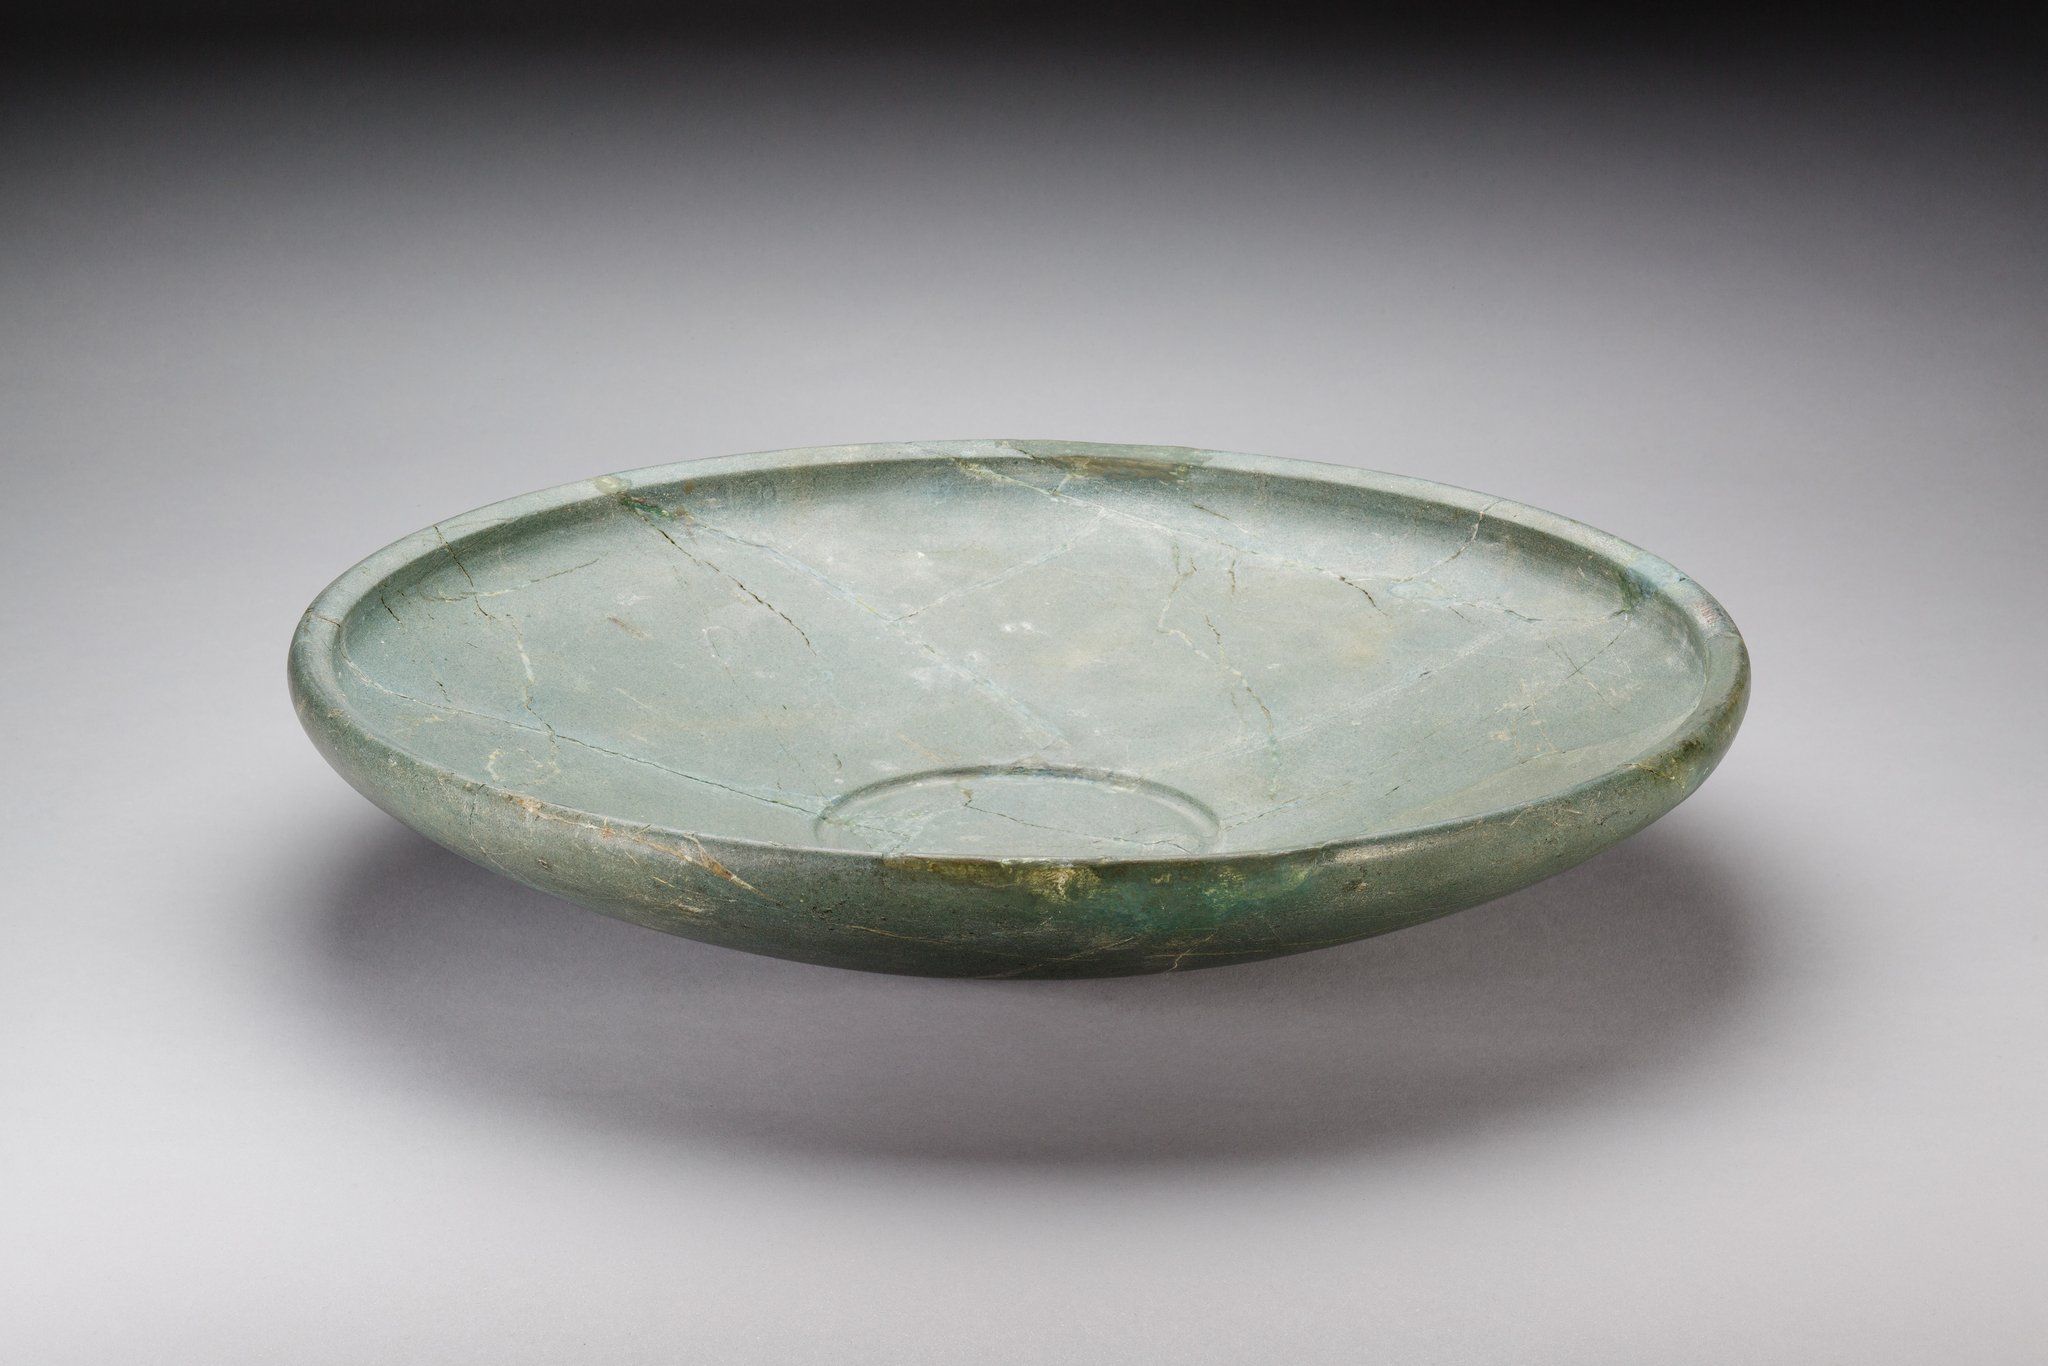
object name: dish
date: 2750-2649 BCE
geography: egypt